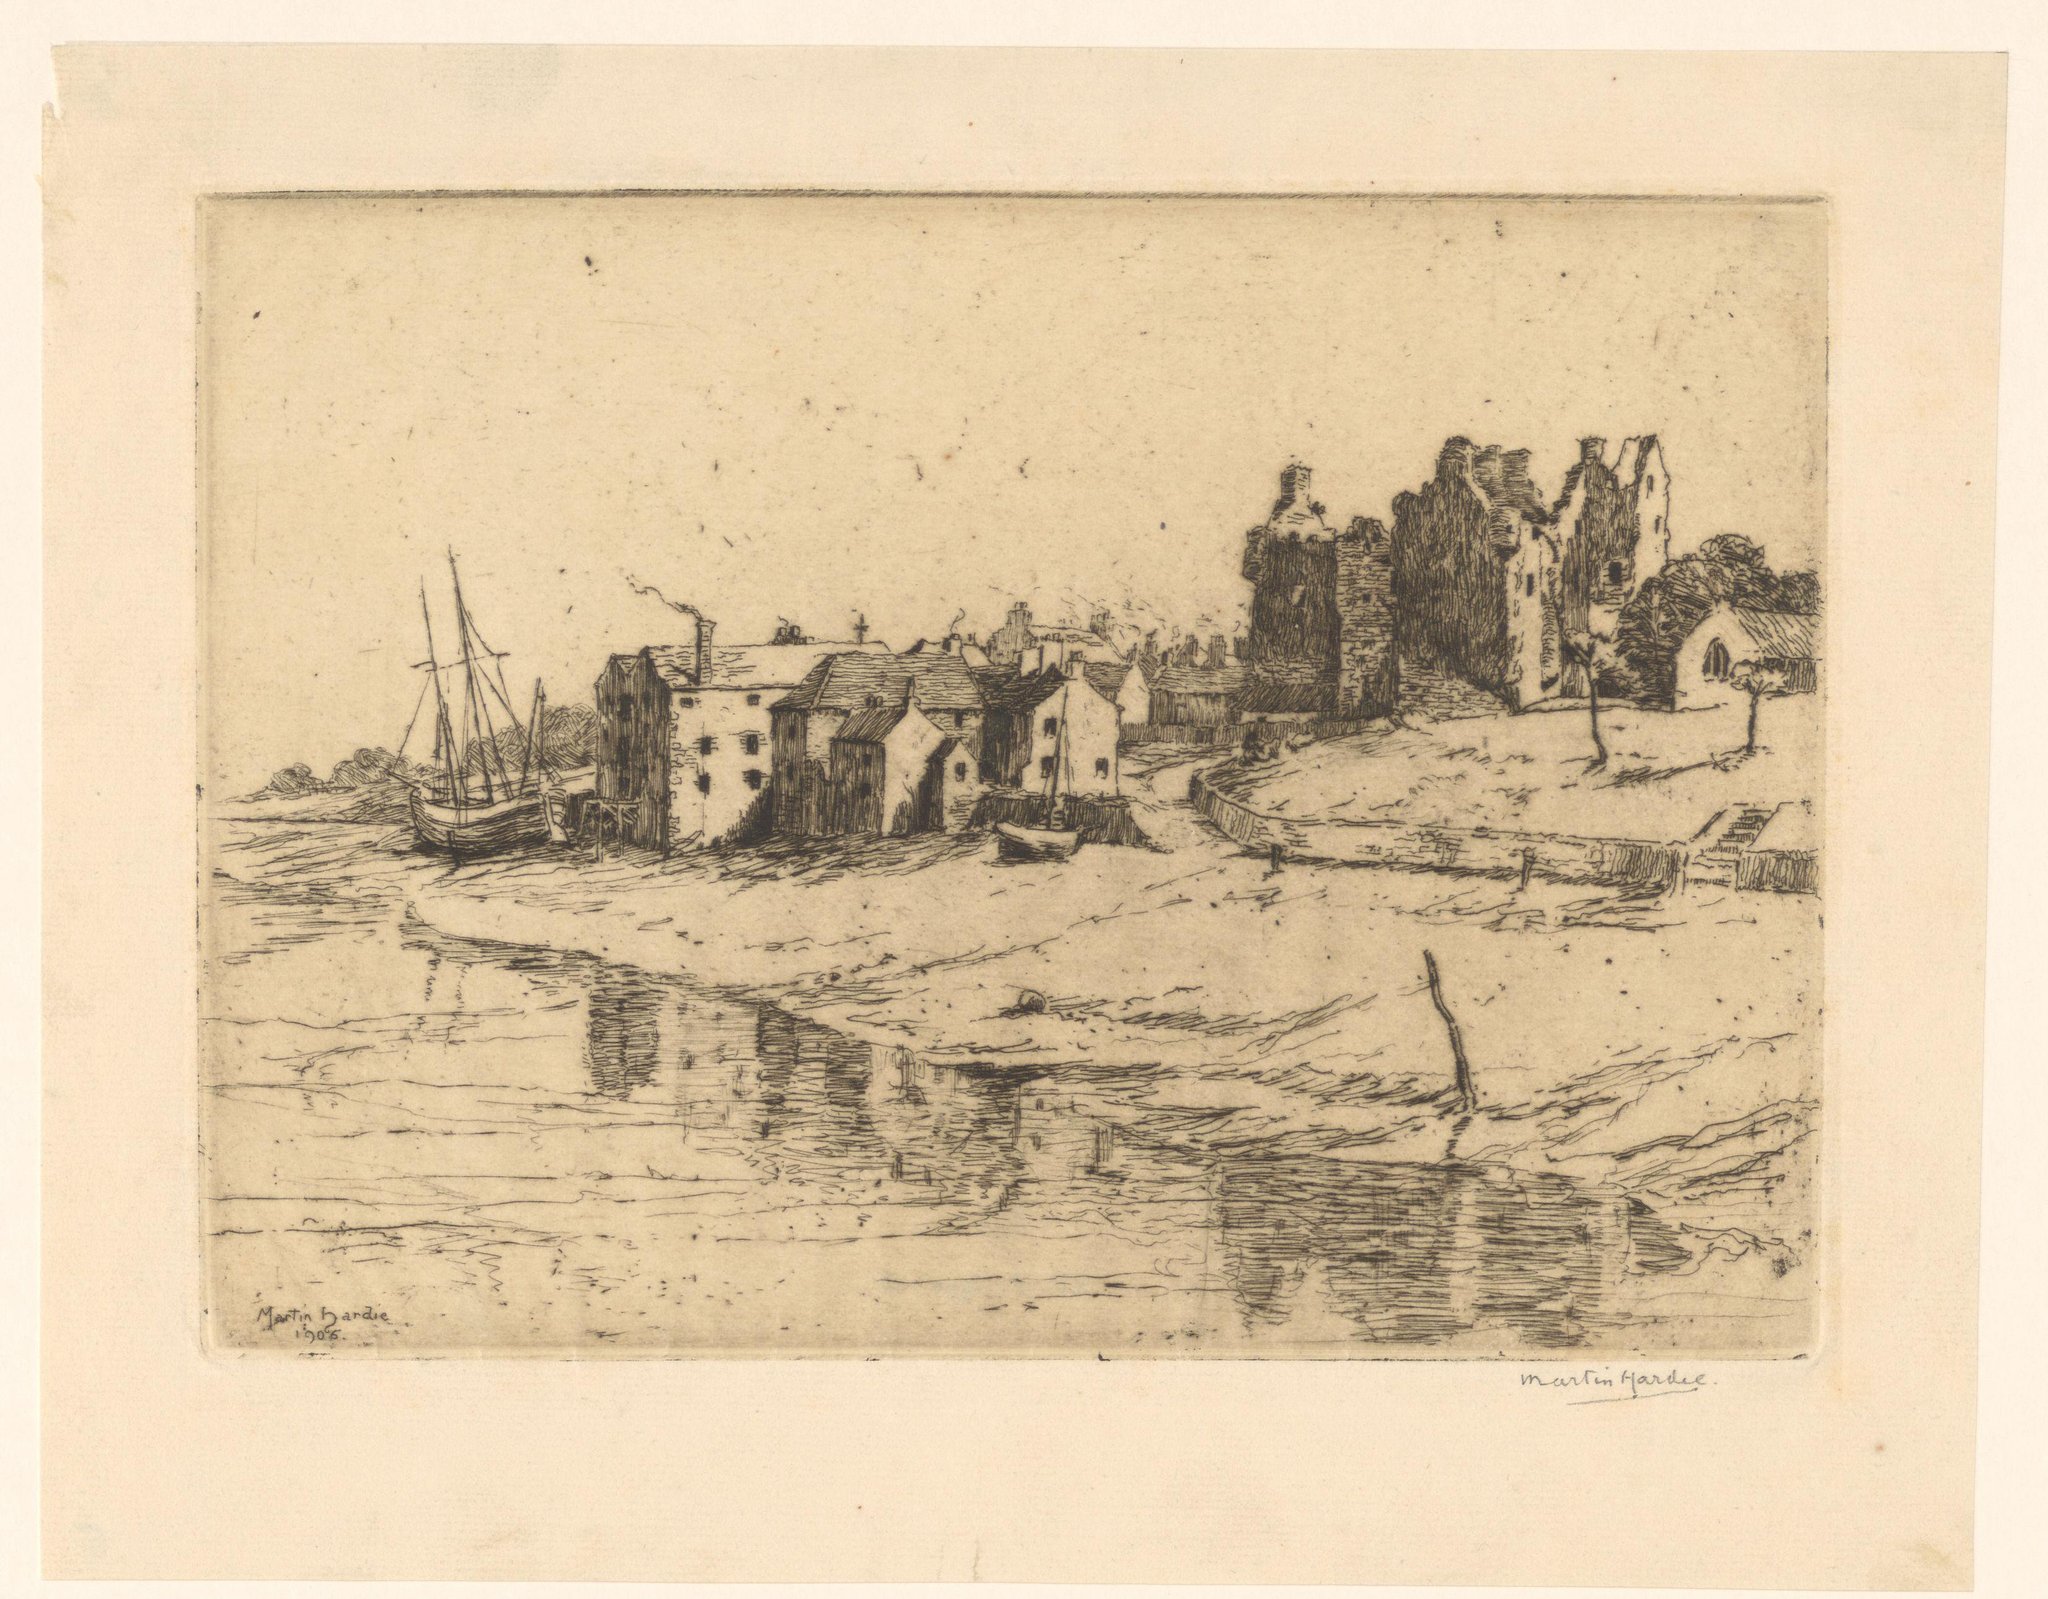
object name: print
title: Gezicht op huizen aan de waterkant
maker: martin hardie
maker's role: print maker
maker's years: 1875-1952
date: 1906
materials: paper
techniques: etching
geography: kirkcudbright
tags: coast, prospect of village, silhouette of village (+ city(-scape) with figures, staffage)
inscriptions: collector's mark: Lugt 2760, collector's mark: Lugt 2228, annotation: ‘Martin Hardie’